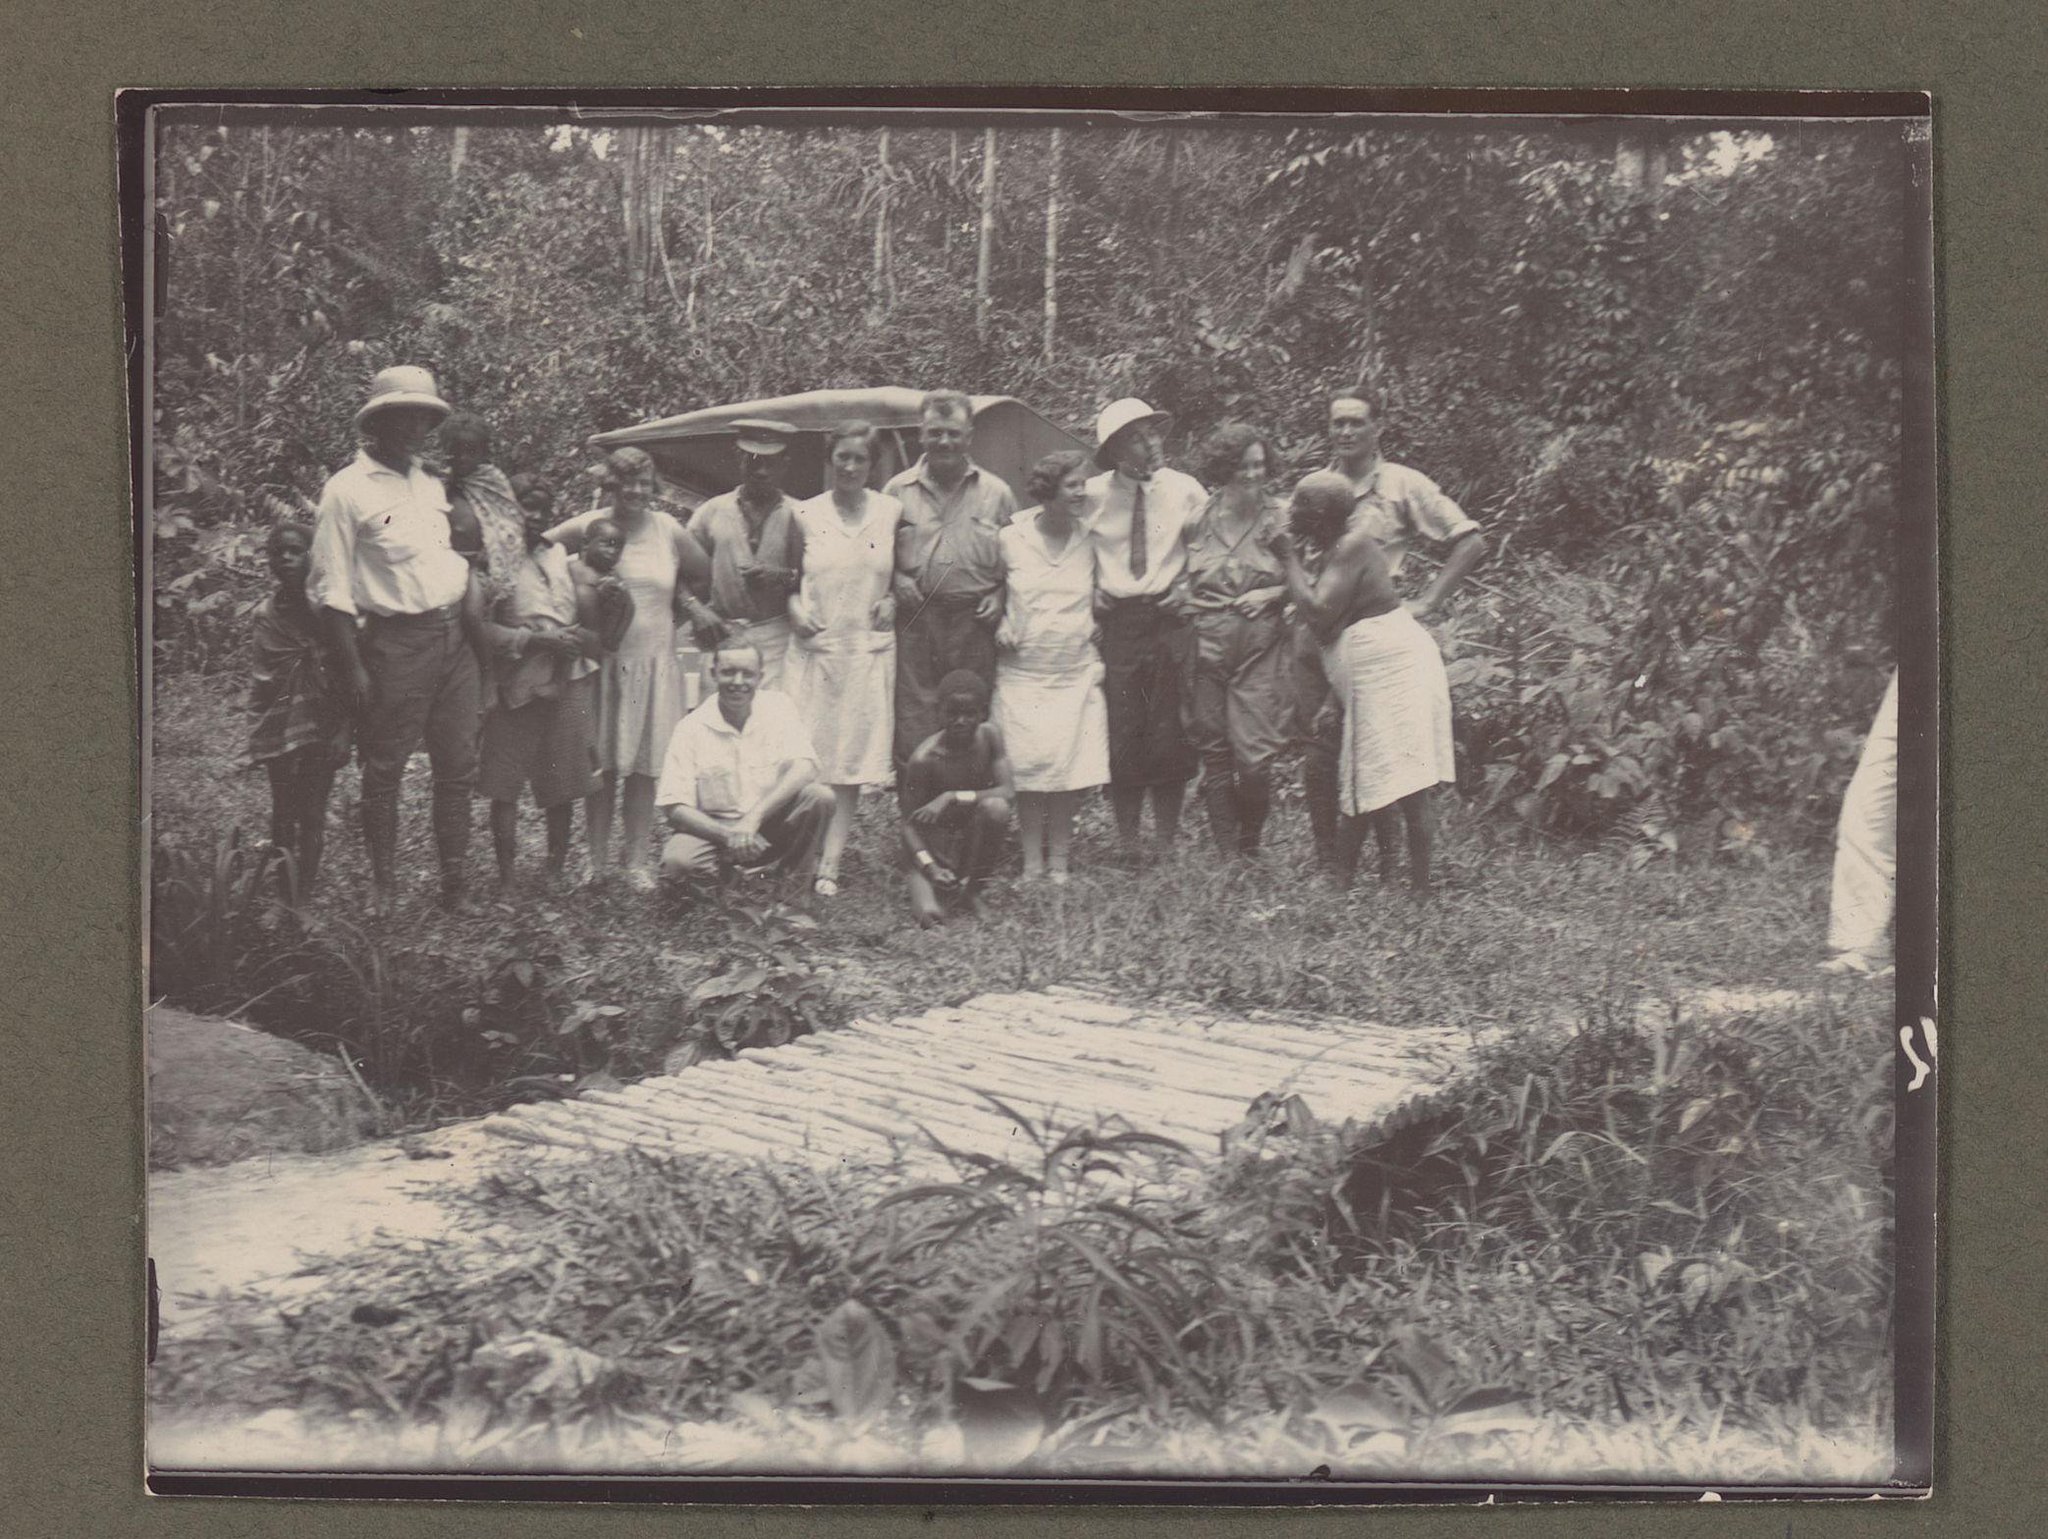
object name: photograph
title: Bezoek aan een inlands dorp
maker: Anonymous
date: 1925-1927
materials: photographic support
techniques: photography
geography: suriname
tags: jetten, familie, moengo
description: Bezoek aan een inlands dorp door een groep Nederlanders waaronder het echtpaar Jetten. Foto op een bladzijde van een los albumblad. Onderdeel van het ensemble met foto's van de familie van ingenieur Jetten in de mijnbouwstad Moengo in Suriname.